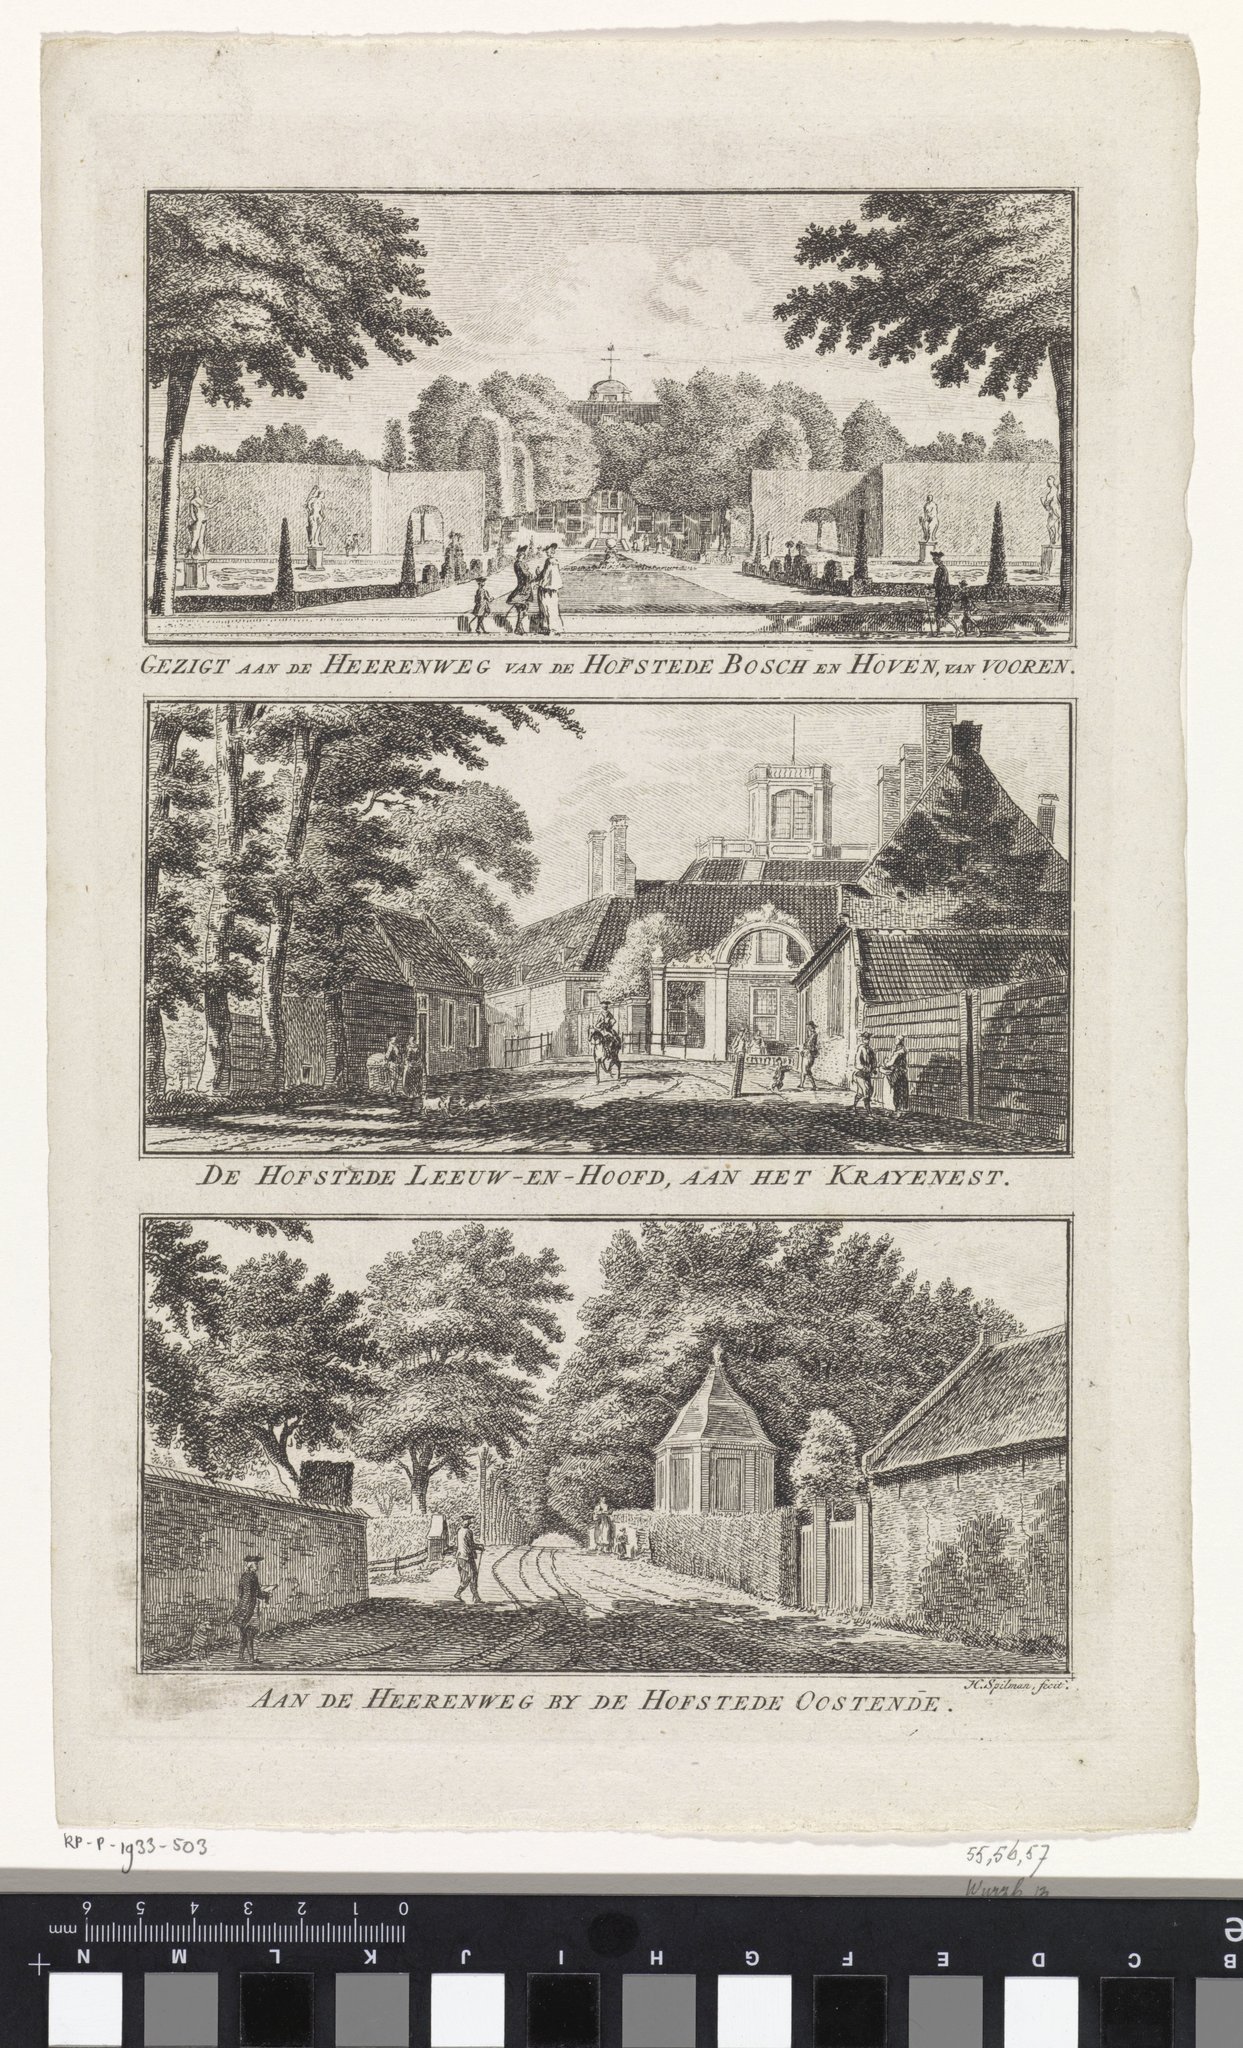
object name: book illustration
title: Drietallen gezichten rond Haarlem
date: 1763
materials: paper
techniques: etching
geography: haarlem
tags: trees, open-air recreation, lane, alley, haarlem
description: Prent gebruikt in: Verzaameling van 66 aangenaame gezichten in de vermakelyke landsdouwen van Haarlem, nieuwlings naar 't leeven getekend door de beroemde konstenaars H. Spilman en C.V. Noorde : nevens eene afbeelding van het laatst angelegde Bosch in het Haarlemsche Hout. Haarlem: J. Bosch, 1763.